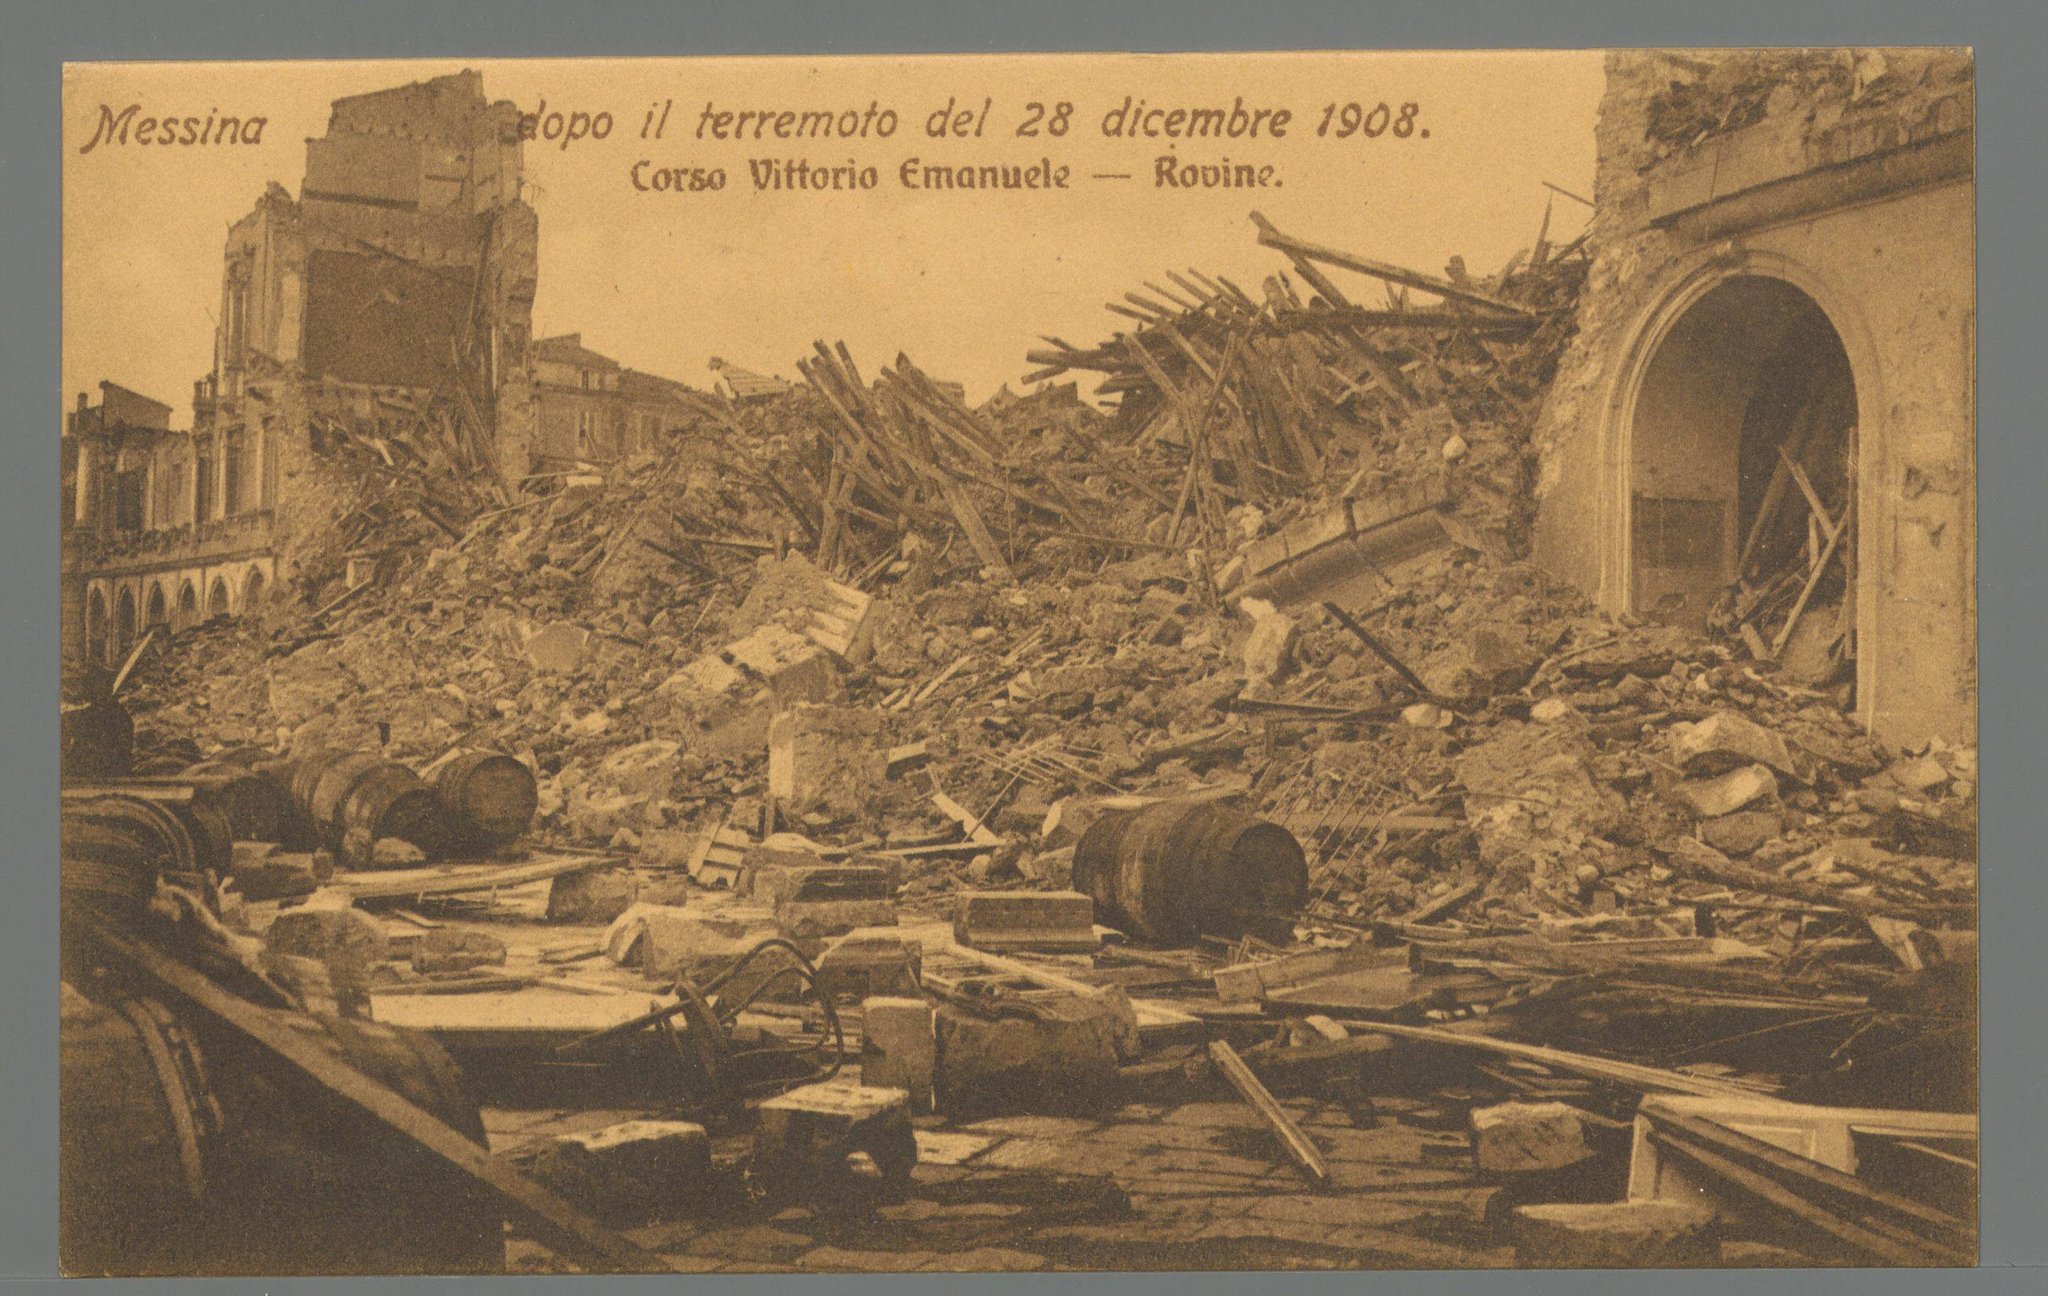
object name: photomechanical print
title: Corso Vittorio Emanuele. Rovine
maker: Anonymous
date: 1908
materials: cardboard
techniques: photograph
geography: milan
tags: city-view, and landscape with man-made constructions, consequences of an earthquake, collapsing building